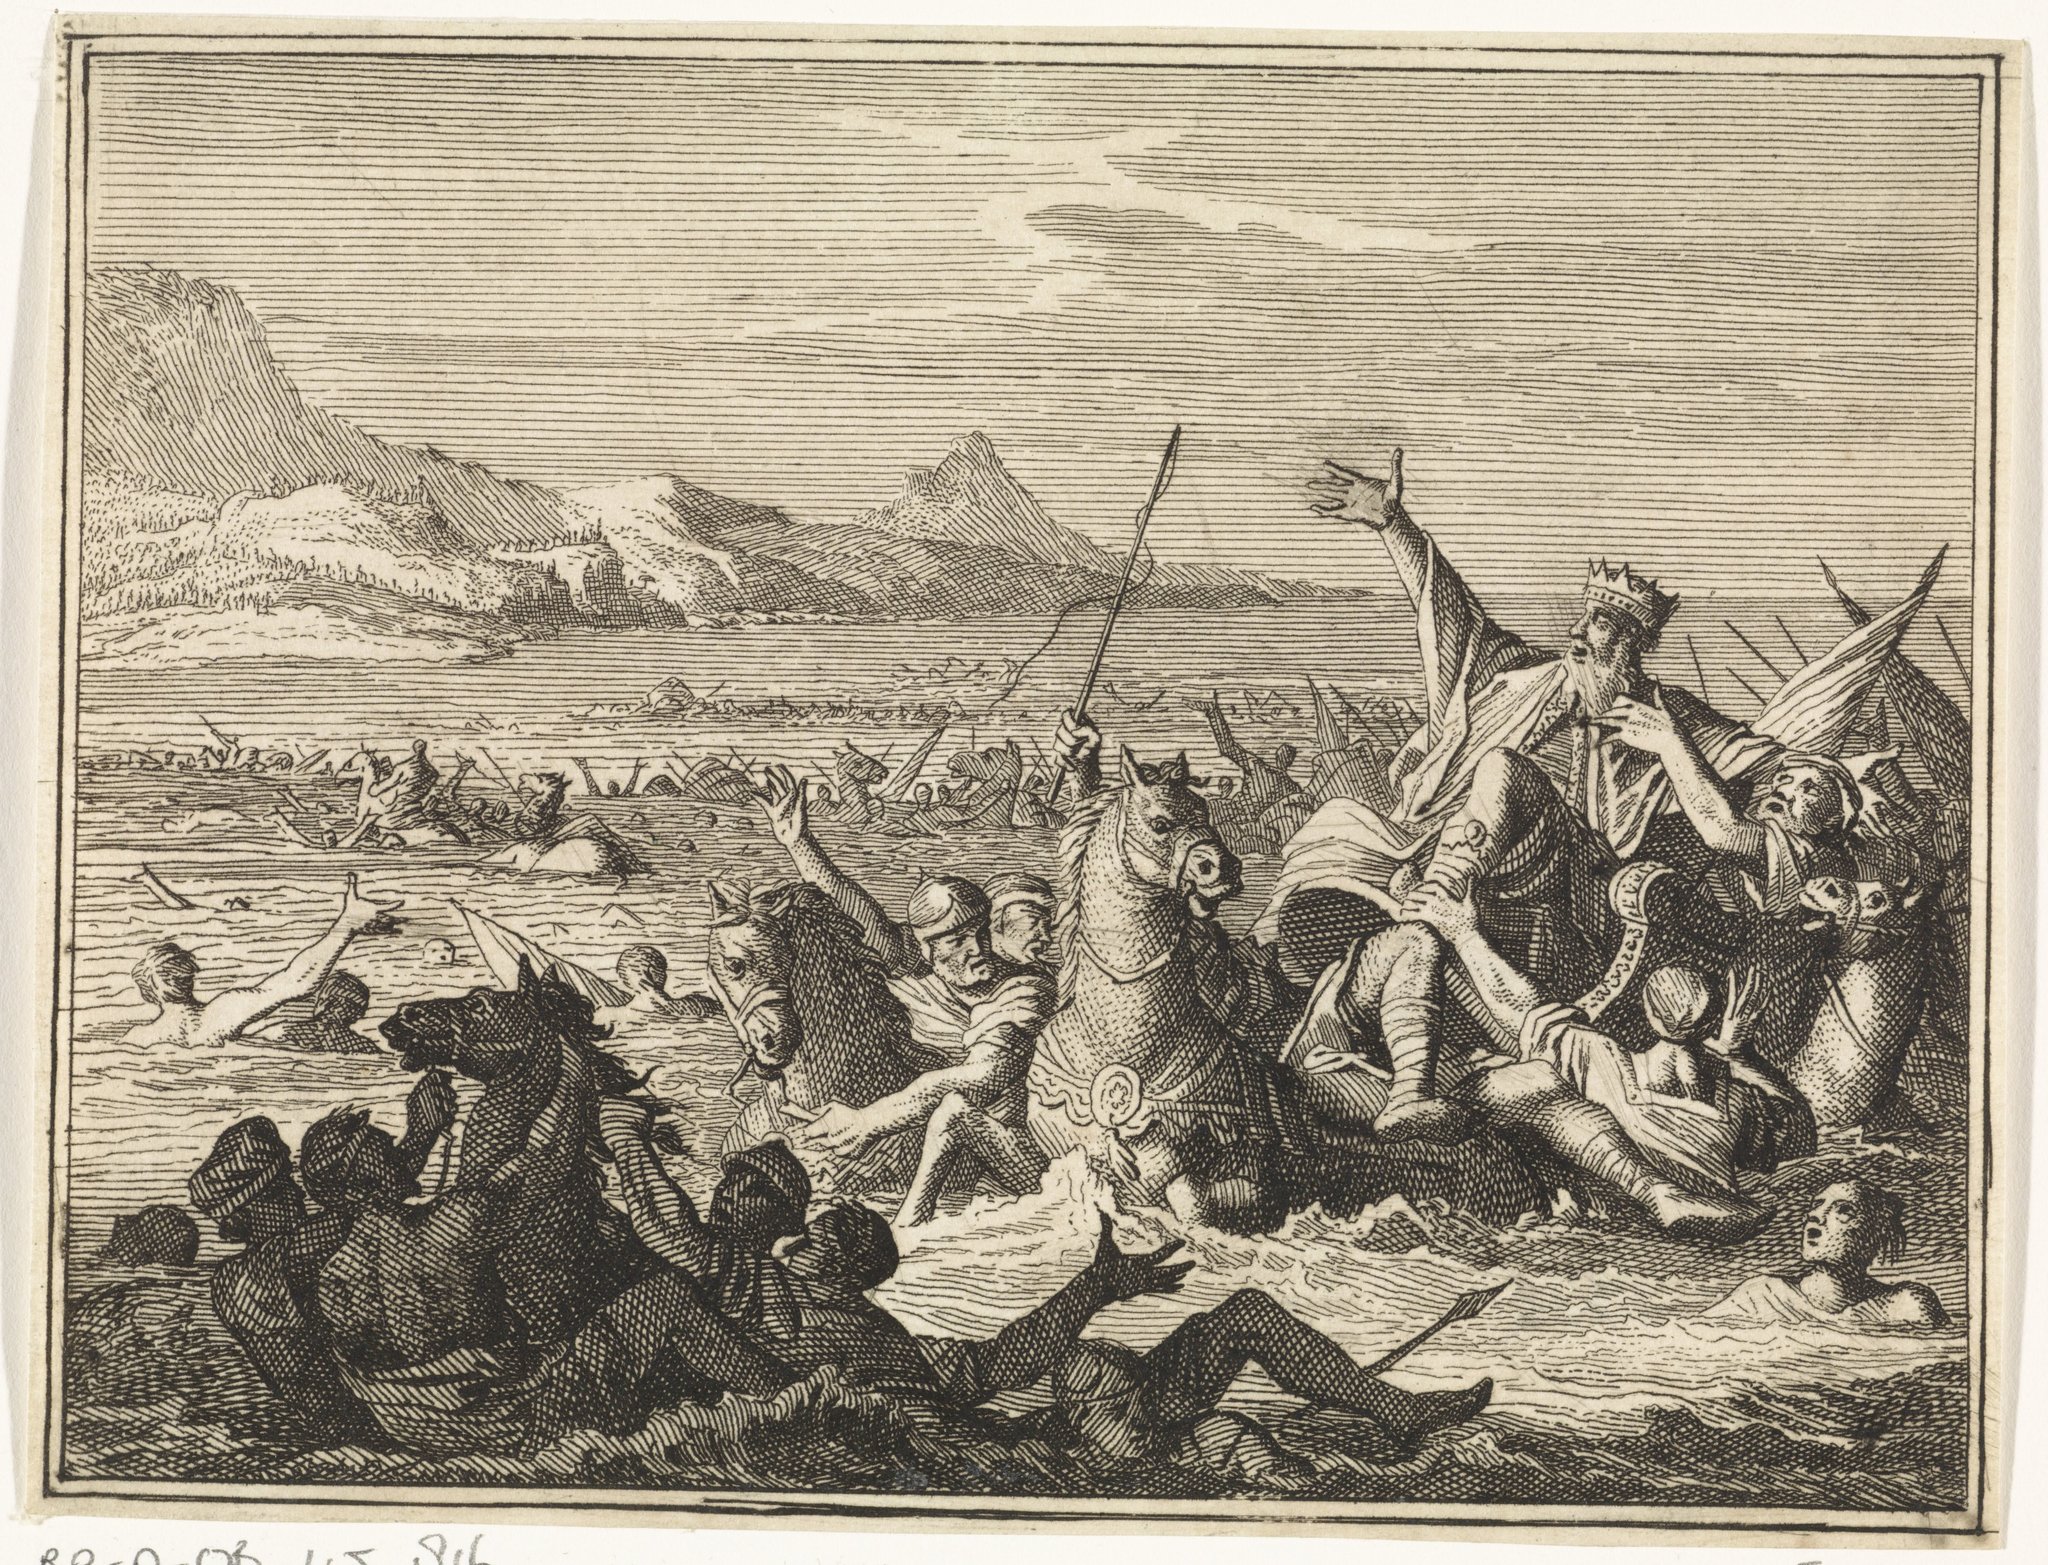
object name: print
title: Farao's leger verdrinkt in de Rode Zee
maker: caspar luyken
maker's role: draughtsman, print maker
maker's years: 1672-1708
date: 1712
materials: paper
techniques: etching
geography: amsterdam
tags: with his people safe on the shore, moses raises his hands and causes the water to return; pharaoh's army perishes in the water (red sea)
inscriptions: number: ‘62’, collector's mark: Lugt 2228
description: Illustratie uit: Luyken, Jan. De schriftuurlyke geschiedenissen en gelykenissen van het Oude en Nieuwe Verbond, 2 delen. Amsterdam: Wed. Pieter Arentsz II en Cornelis van der Sys, 1712, dl. I.